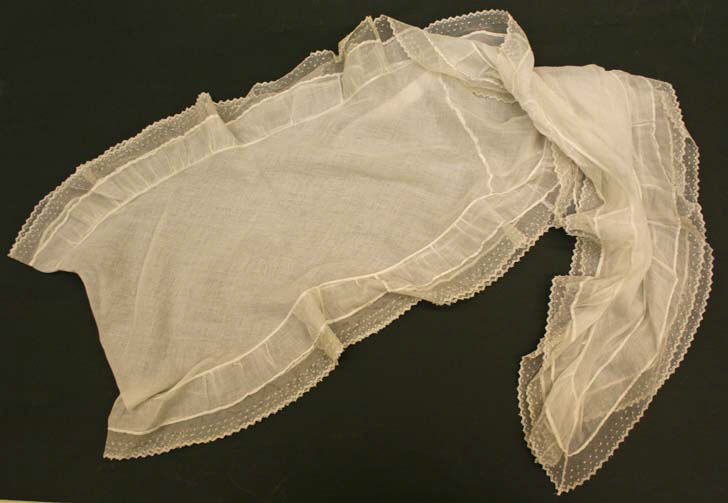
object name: collar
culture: american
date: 1800-1820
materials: cotton